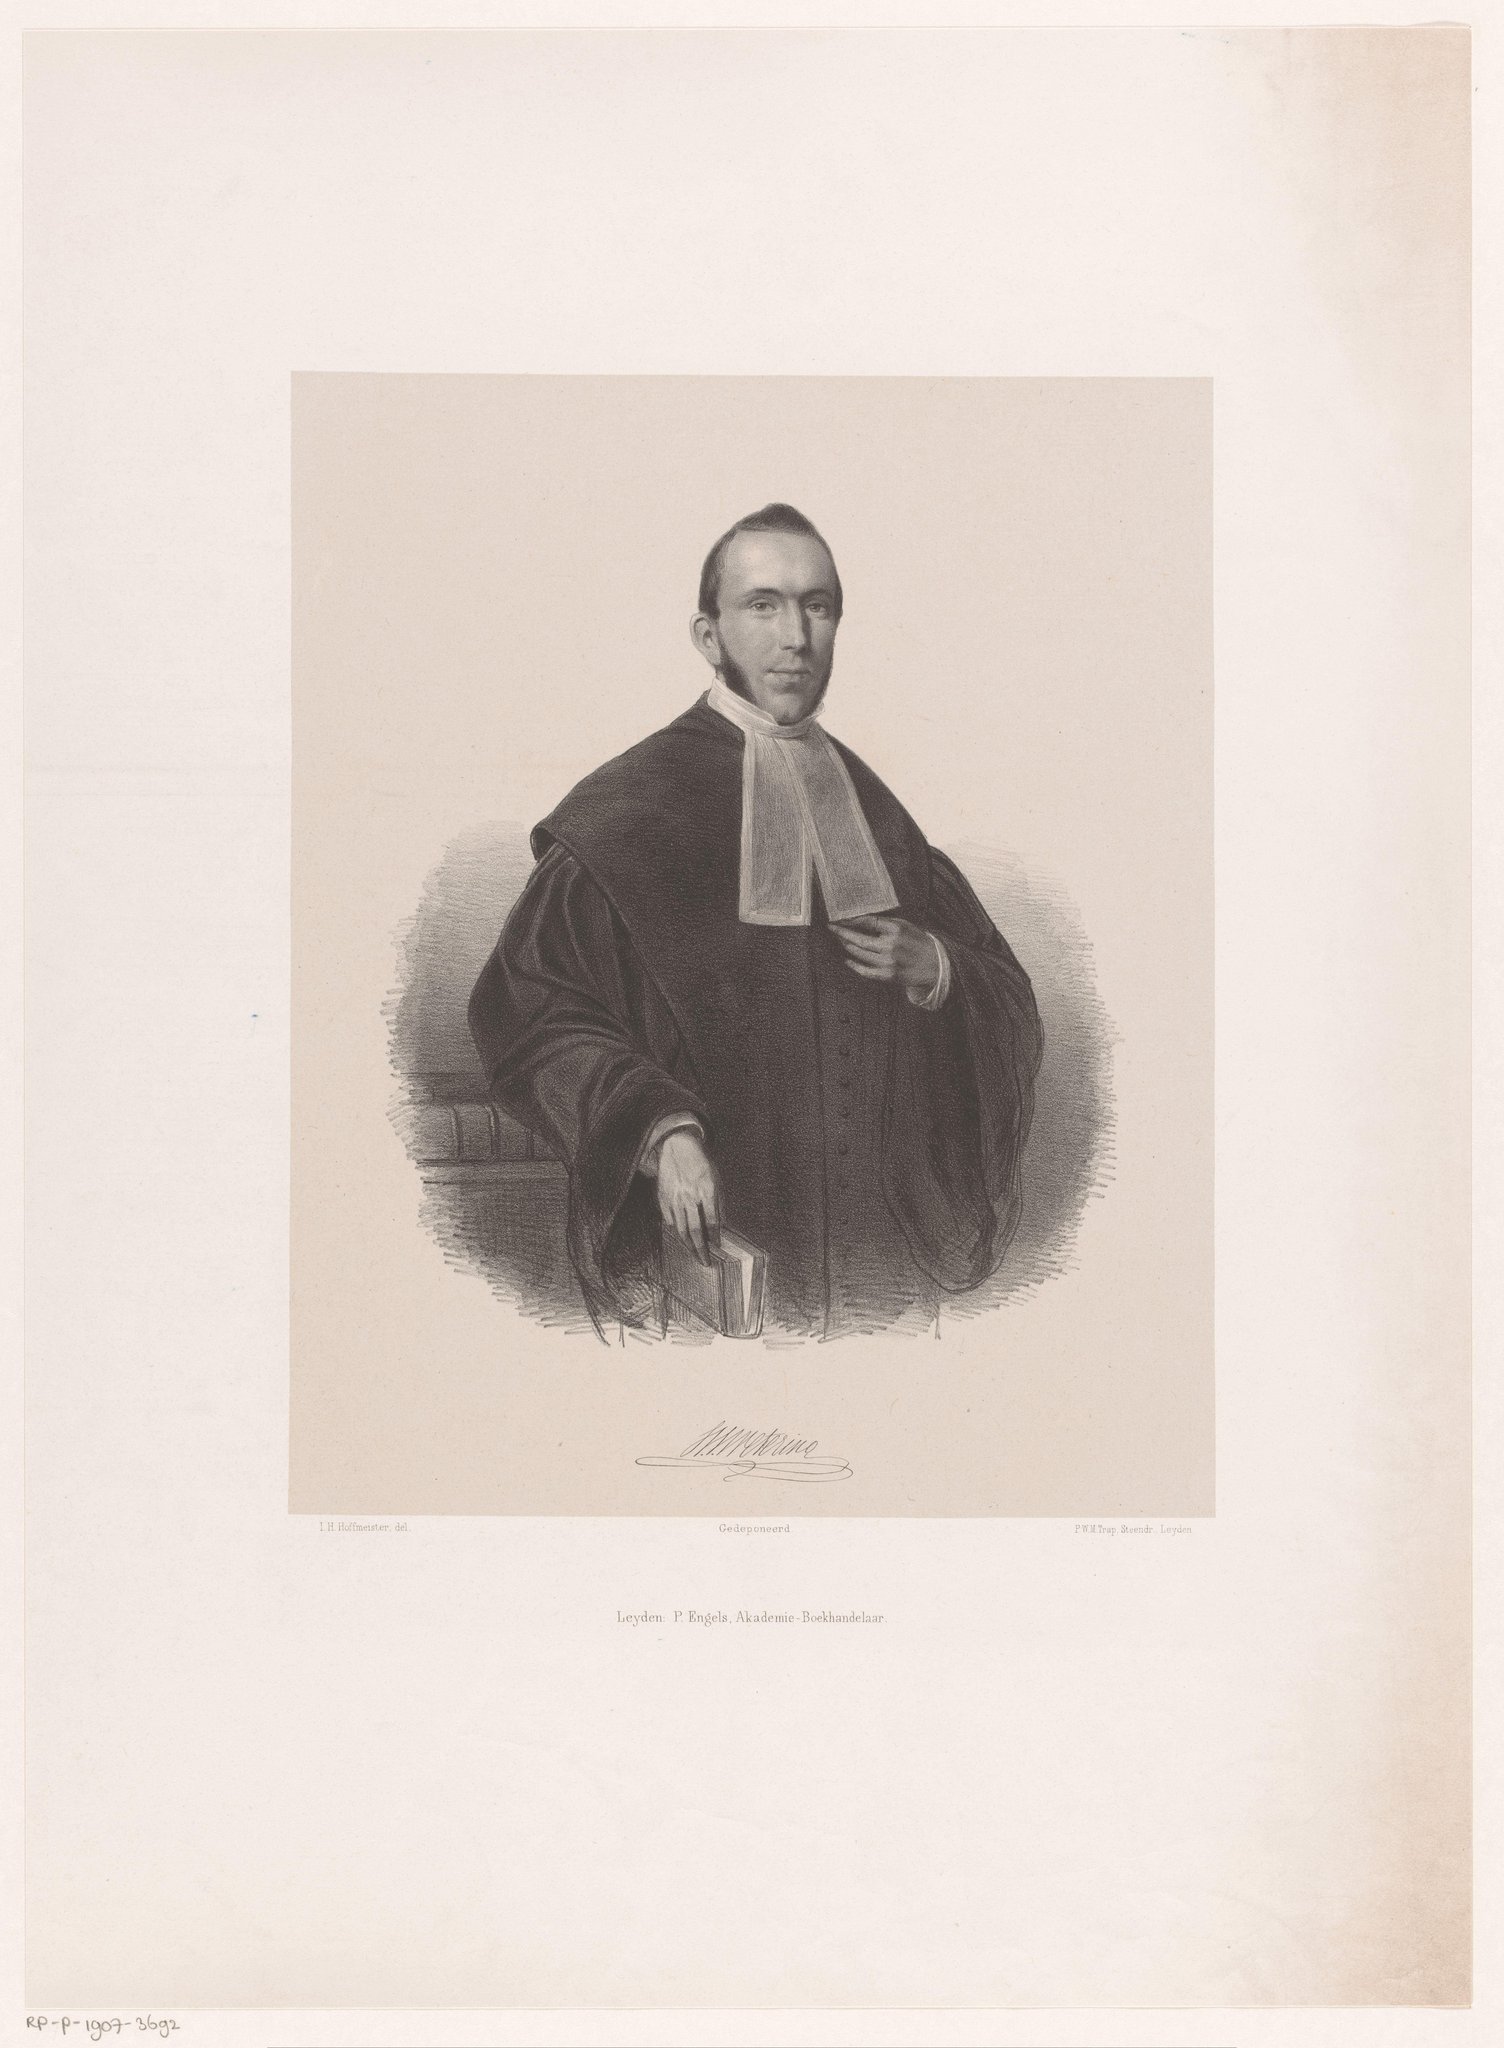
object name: print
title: Portret van W. van Wetering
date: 1843-1890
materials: paper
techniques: lithograph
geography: leiden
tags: book, historical persons (+ three-quarter length portrait)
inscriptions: : ‘Gedponeerd.’, collector's mark: Lugt 2228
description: Onder het portret de signatuur van de geportretteerde.